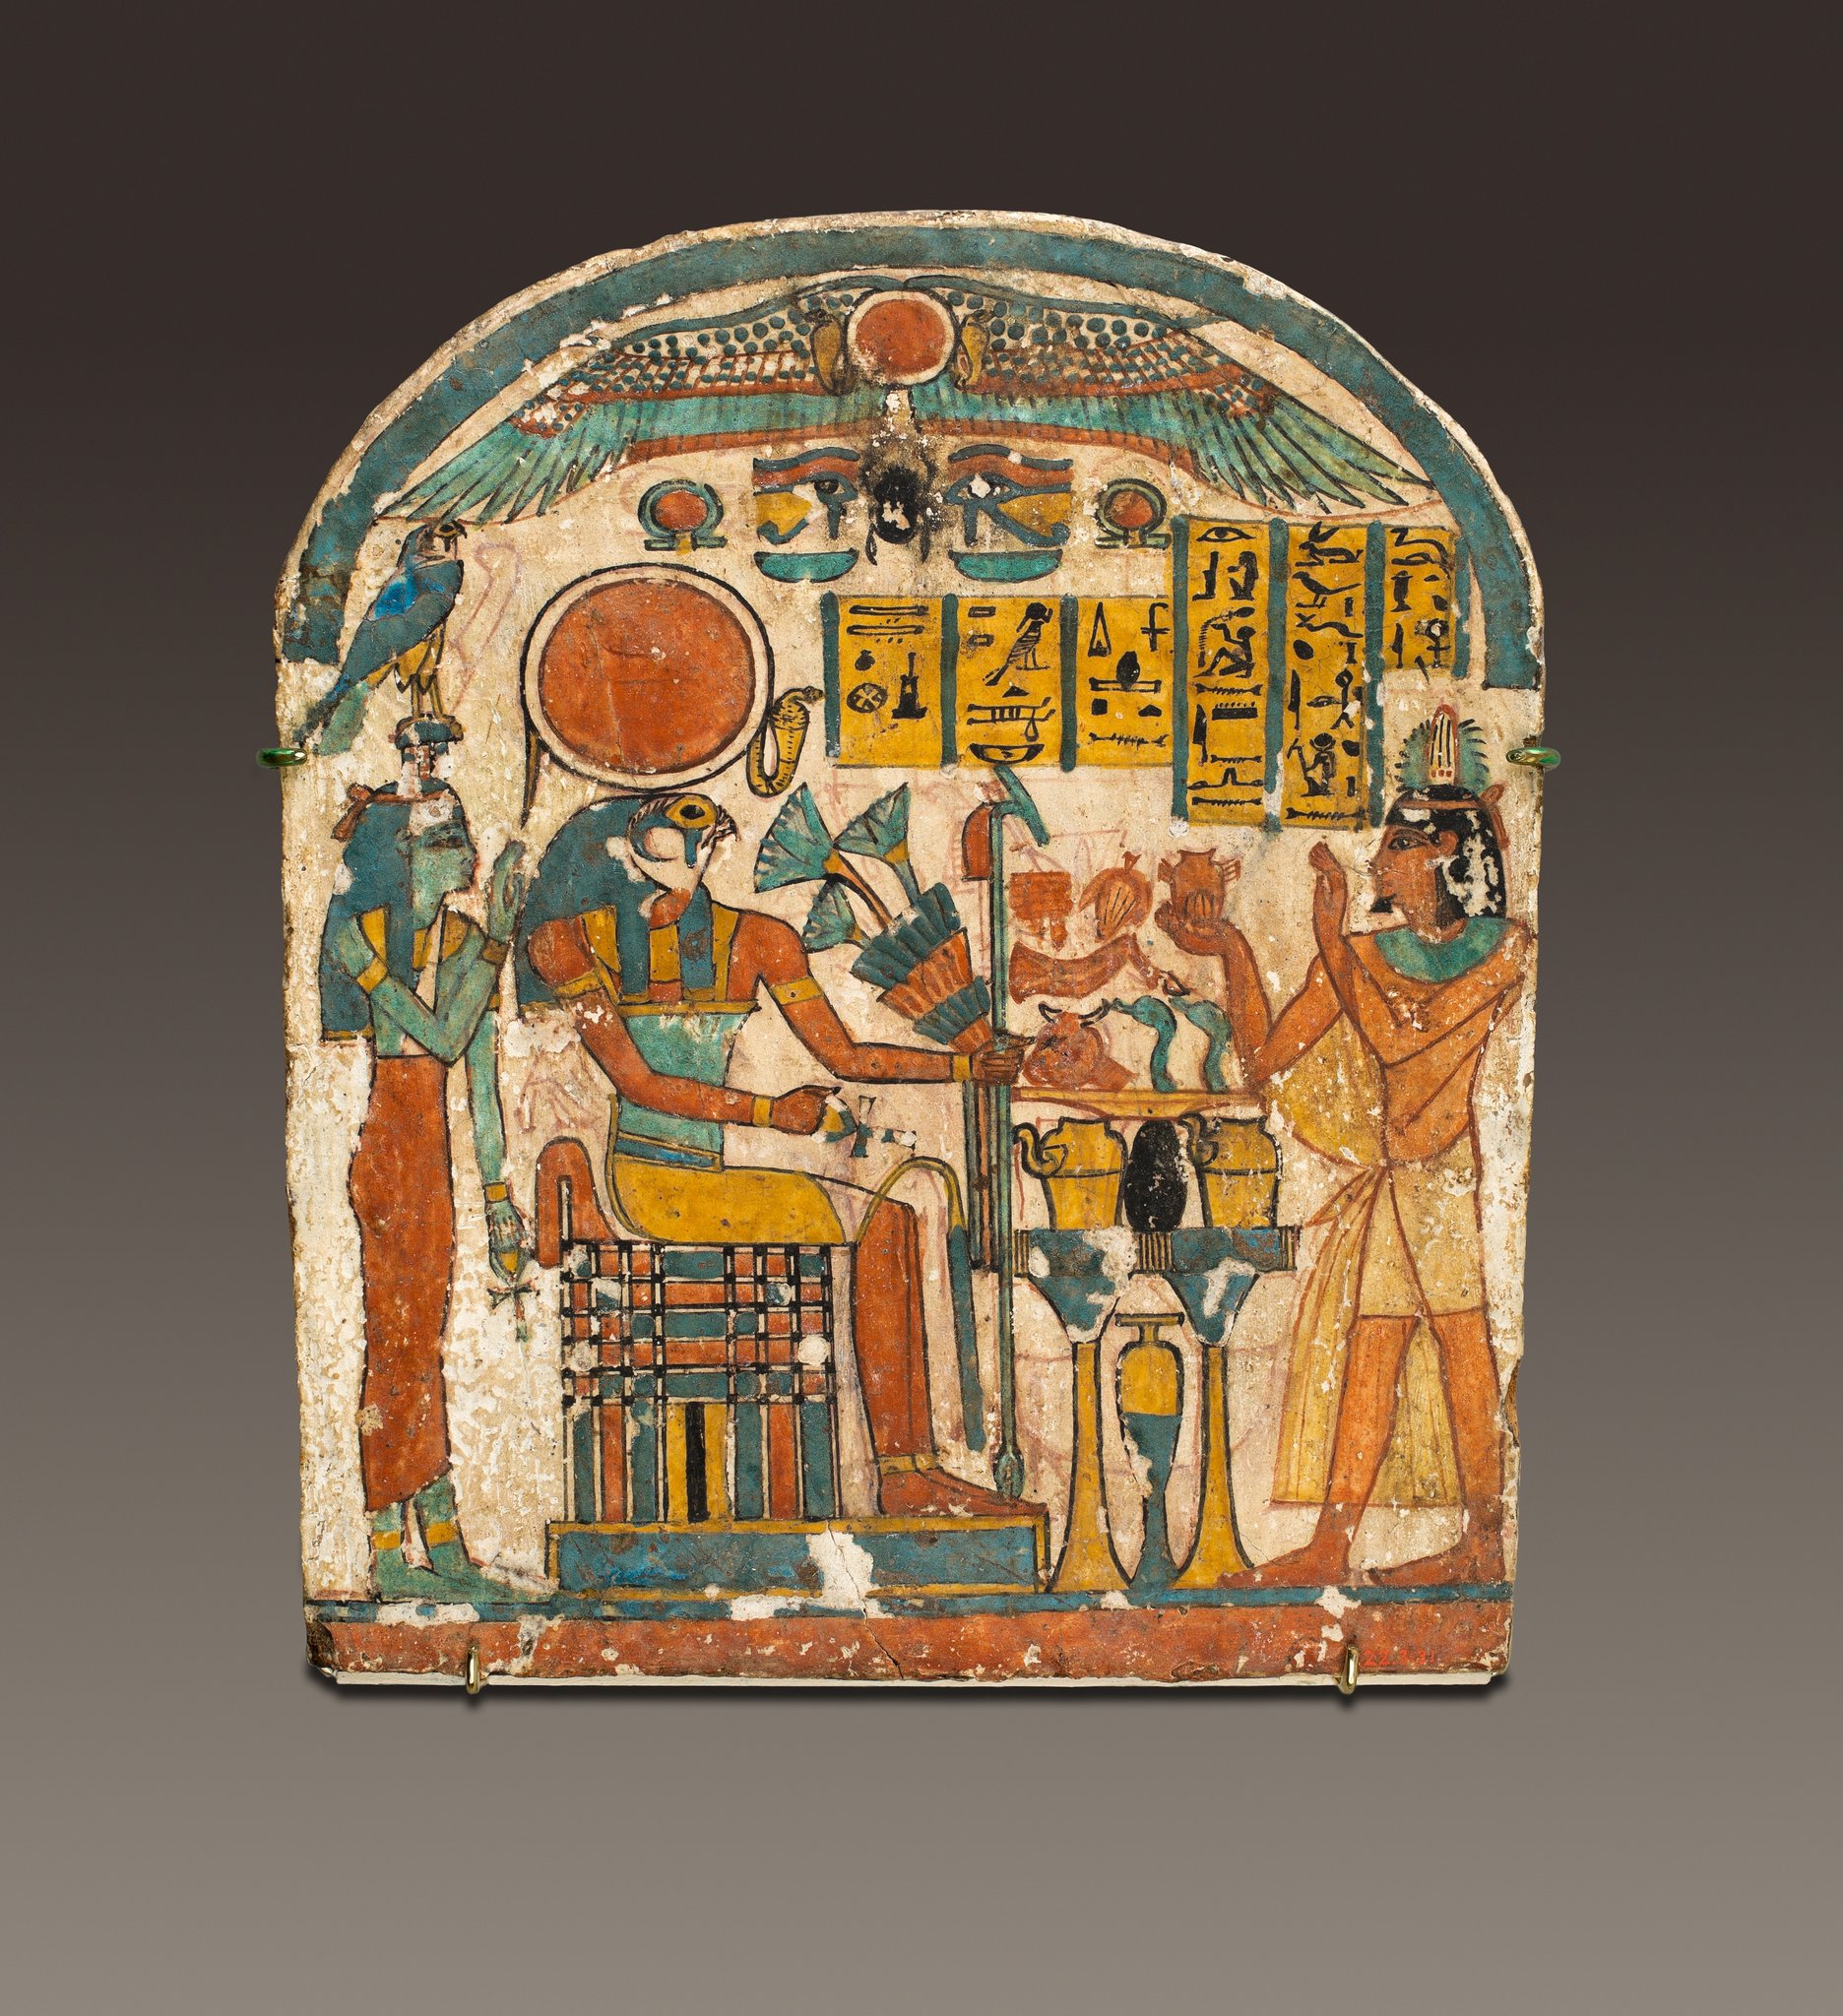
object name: stela, painted, saiah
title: Stela of Saiah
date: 825-712 BCE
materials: paint, paste, wood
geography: egypt